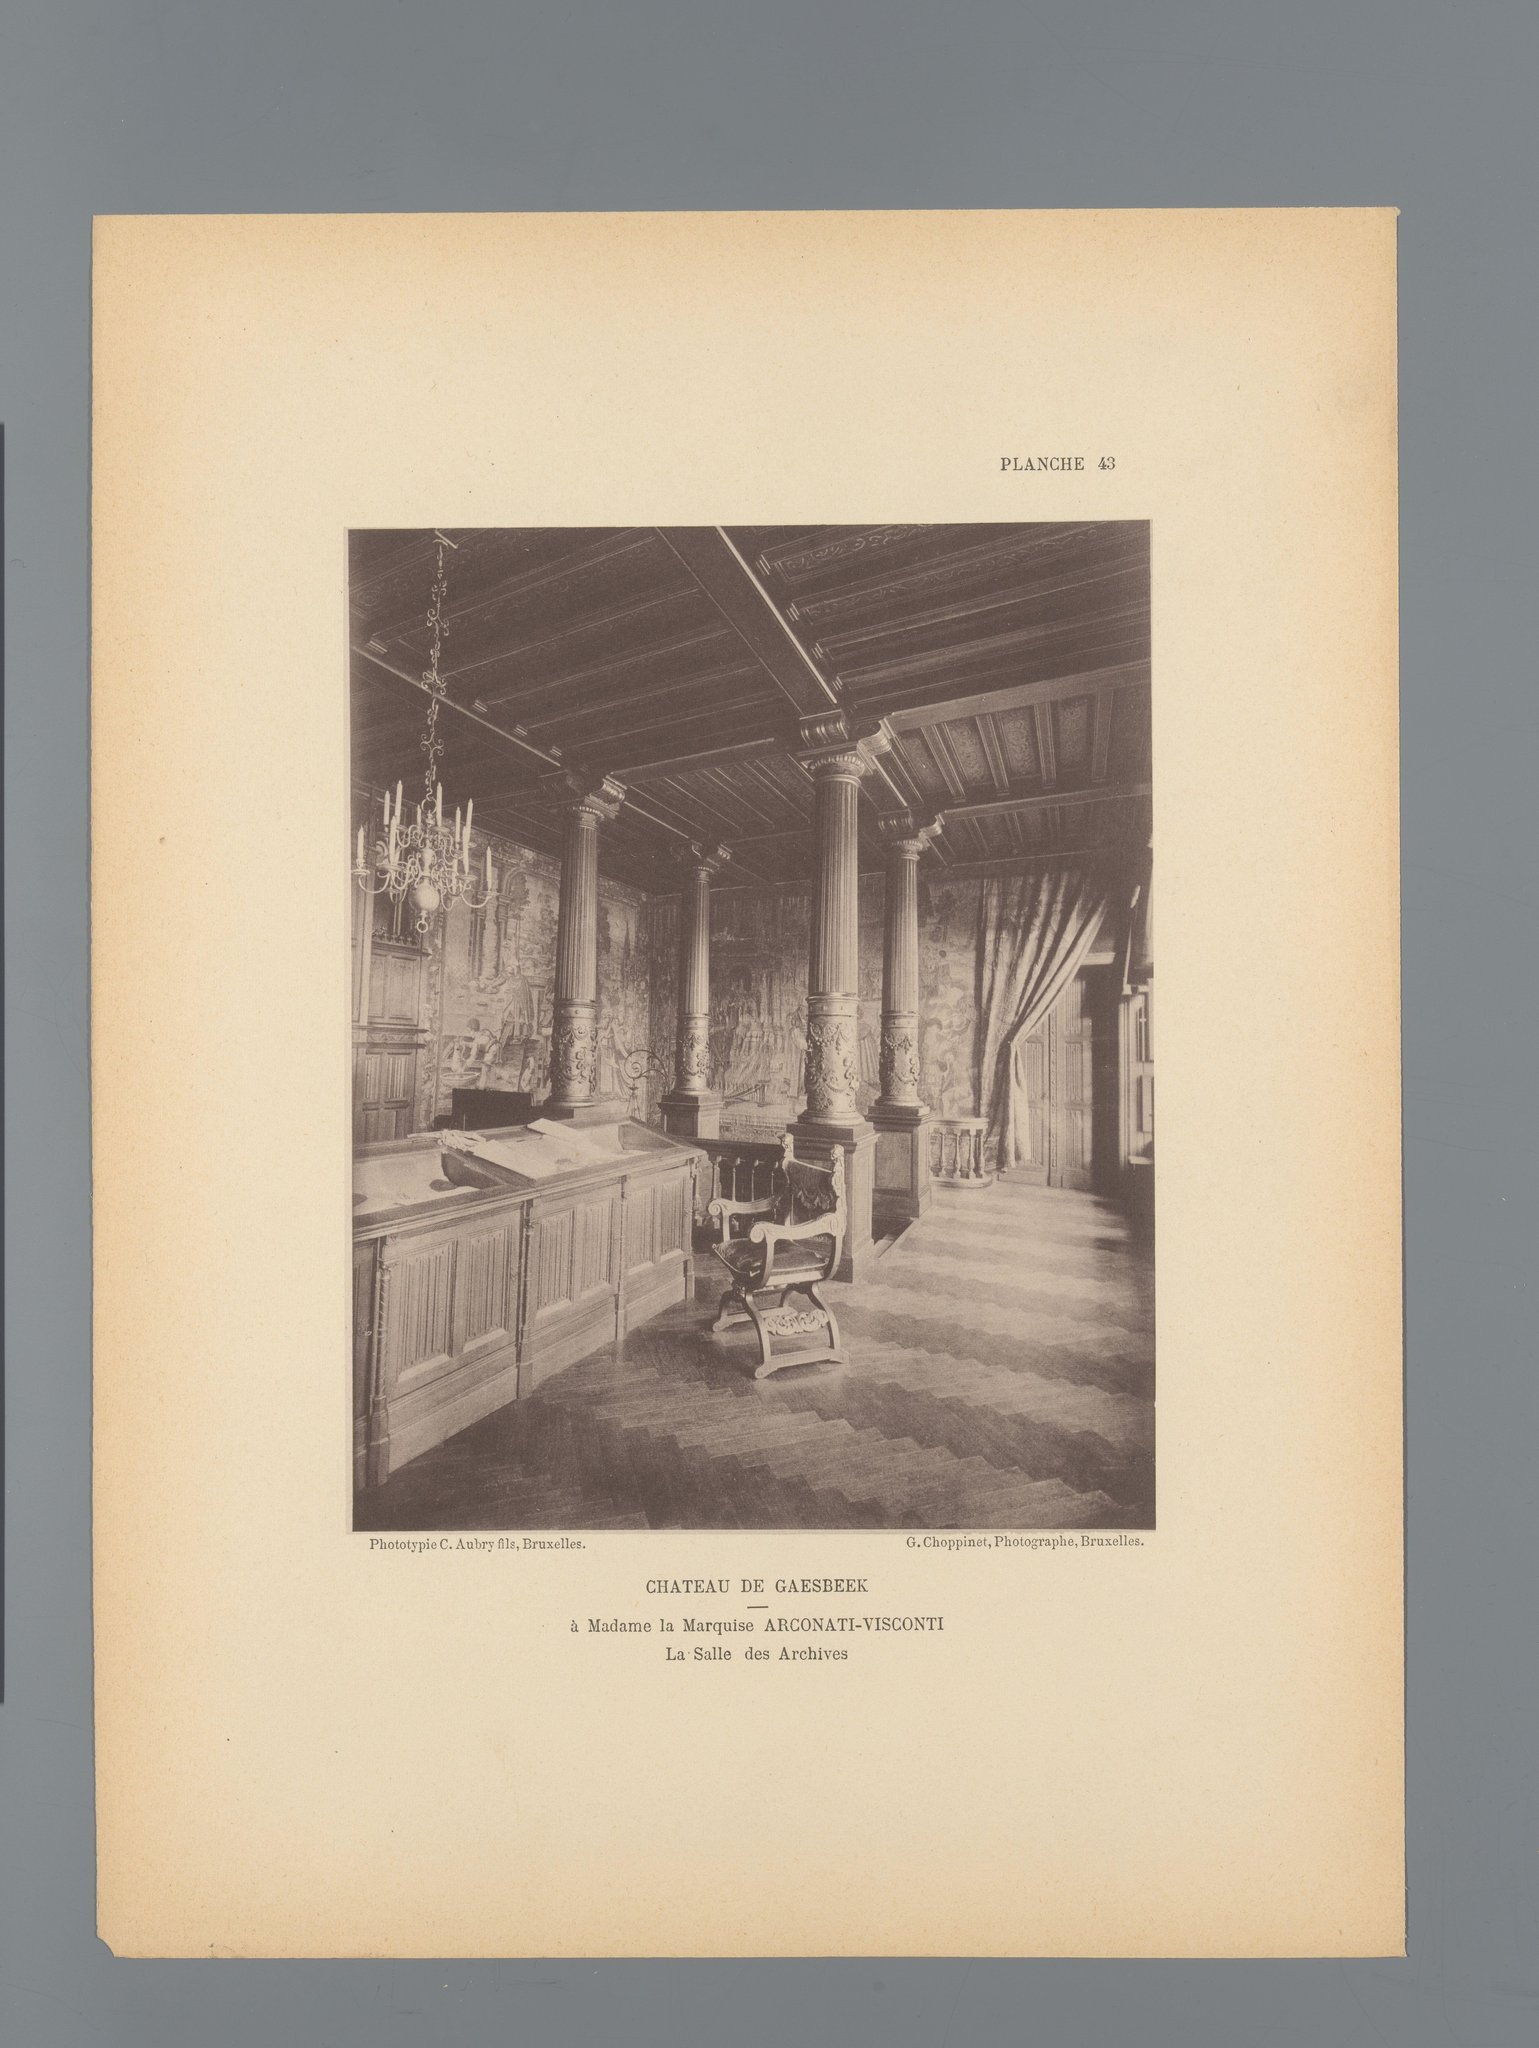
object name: photomechanical print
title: Gezicht op de archiefzaal in het Kasteel van Gaasbeek, België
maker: gustave choppinet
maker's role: fotograaf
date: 1893-1898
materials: paper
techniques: photograph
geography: brussels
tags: archive, castle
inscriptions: number: ‘PLANCHE 43’, inscription: ‘à Madame la Marquise ARCONATI-VISCONTI/ La Salle des Archives’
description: Deze prent maakt deel uit van een omslag met 89 prenten en 5 tekstbladen.